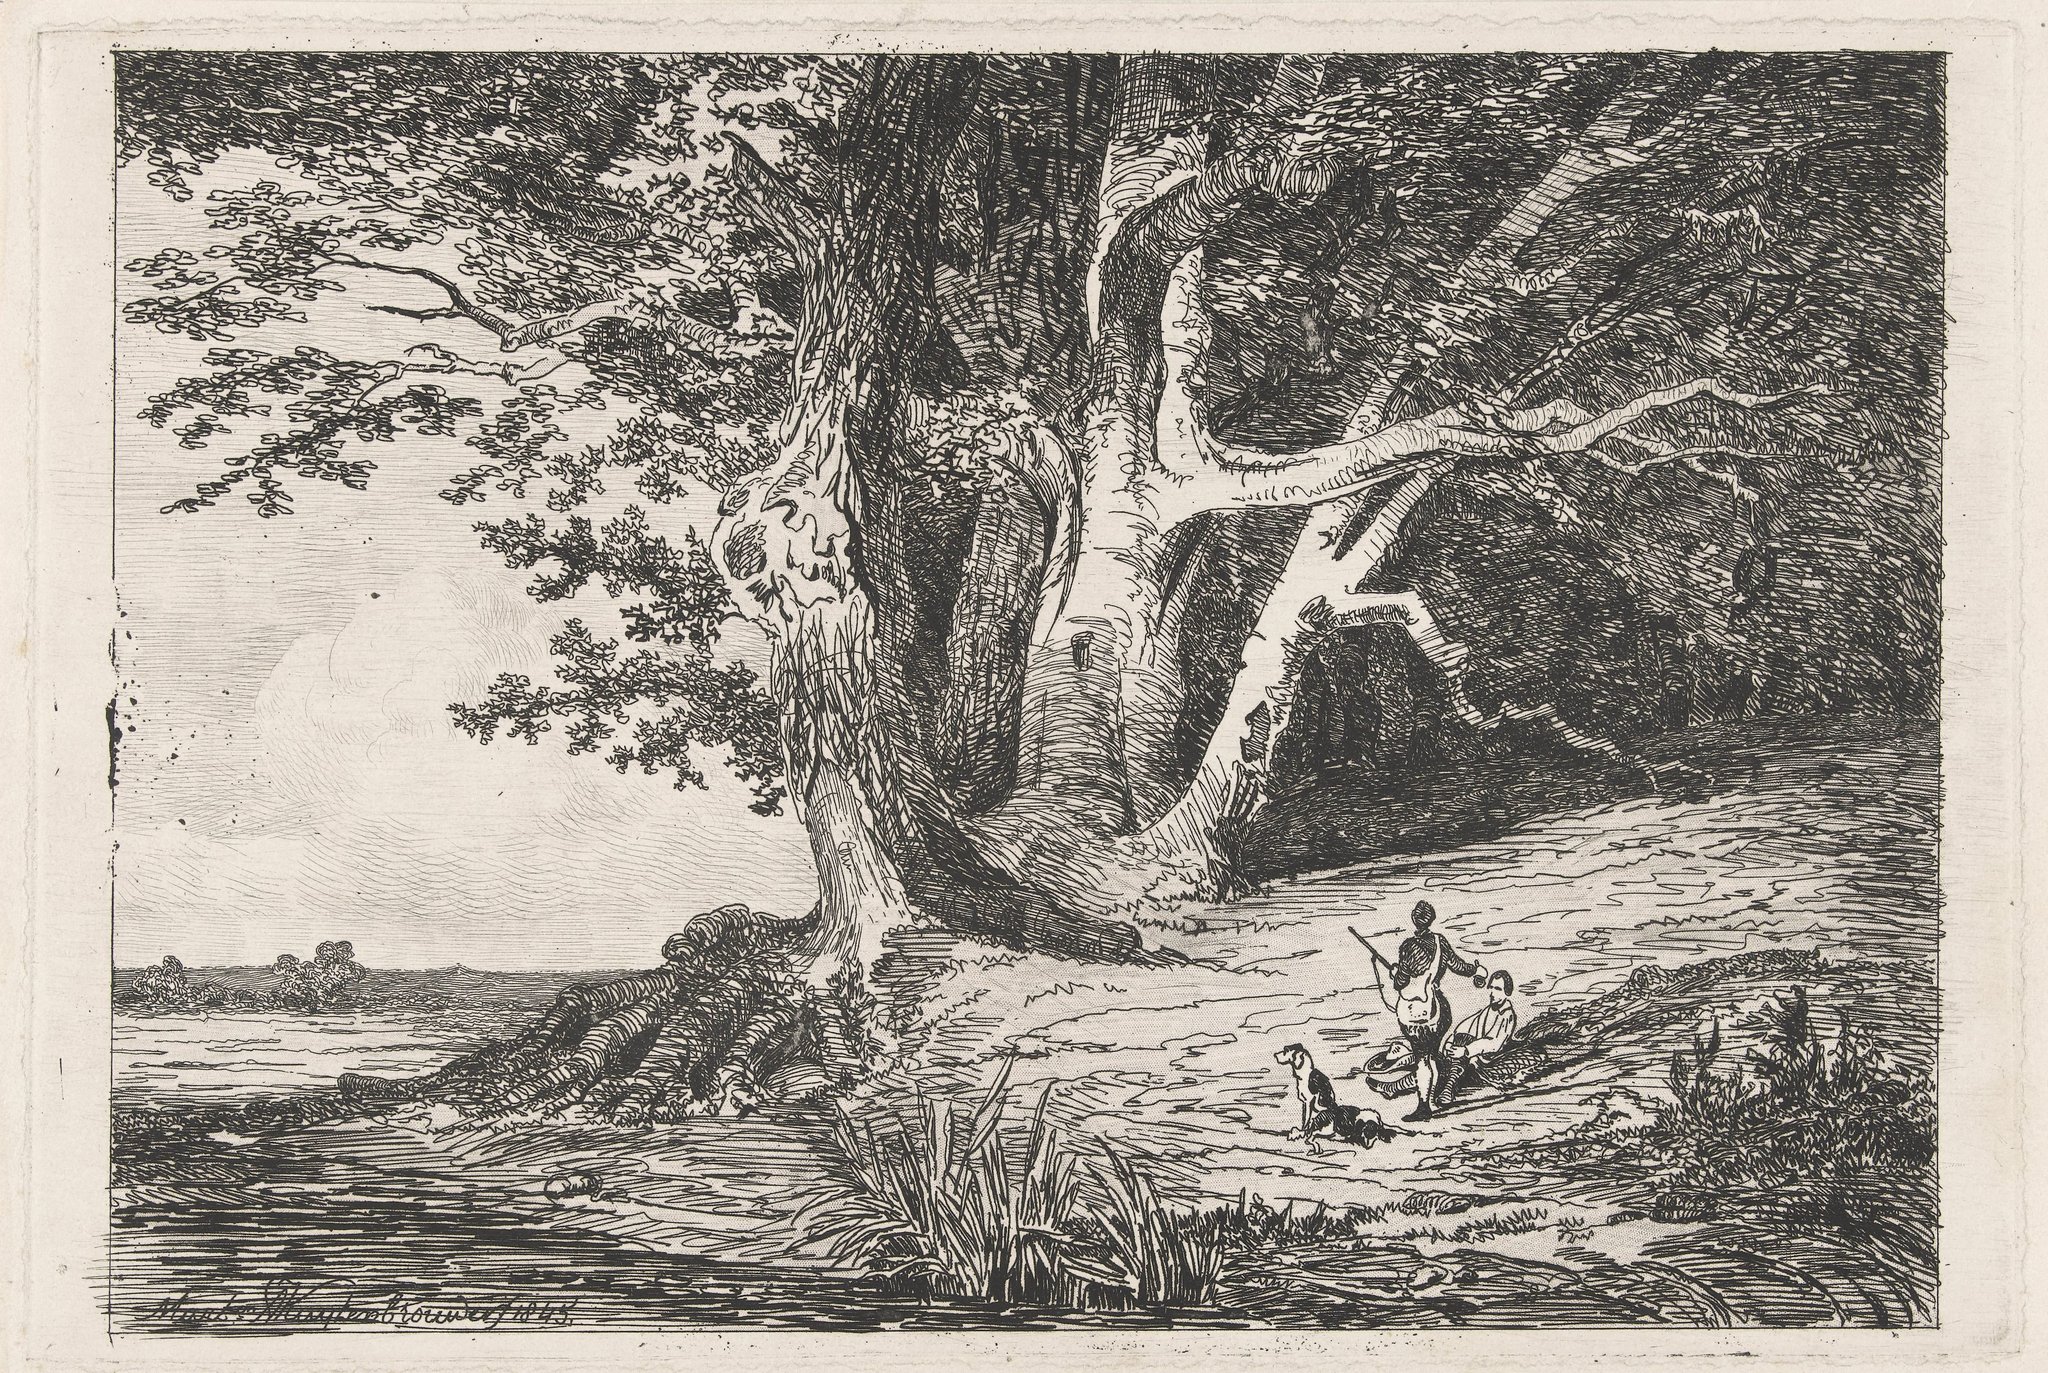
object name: print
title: Twee jagers aan de waterkant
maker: martinus antonius kuytenbrouwer jr.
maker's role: draughtsman, painter, print maker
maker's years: 1821-1897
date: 1845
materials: paper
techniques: drypoint, etching, roulette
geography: the hague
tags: hunters resting during the hunt - cc - female hunter, huntress, trees, river bank, dog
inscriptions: collector's mark: Lugt 2228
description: Aan een waterkant, waar een grote boom staat, bevinden zich twee rustende jagers en hun twee honden.